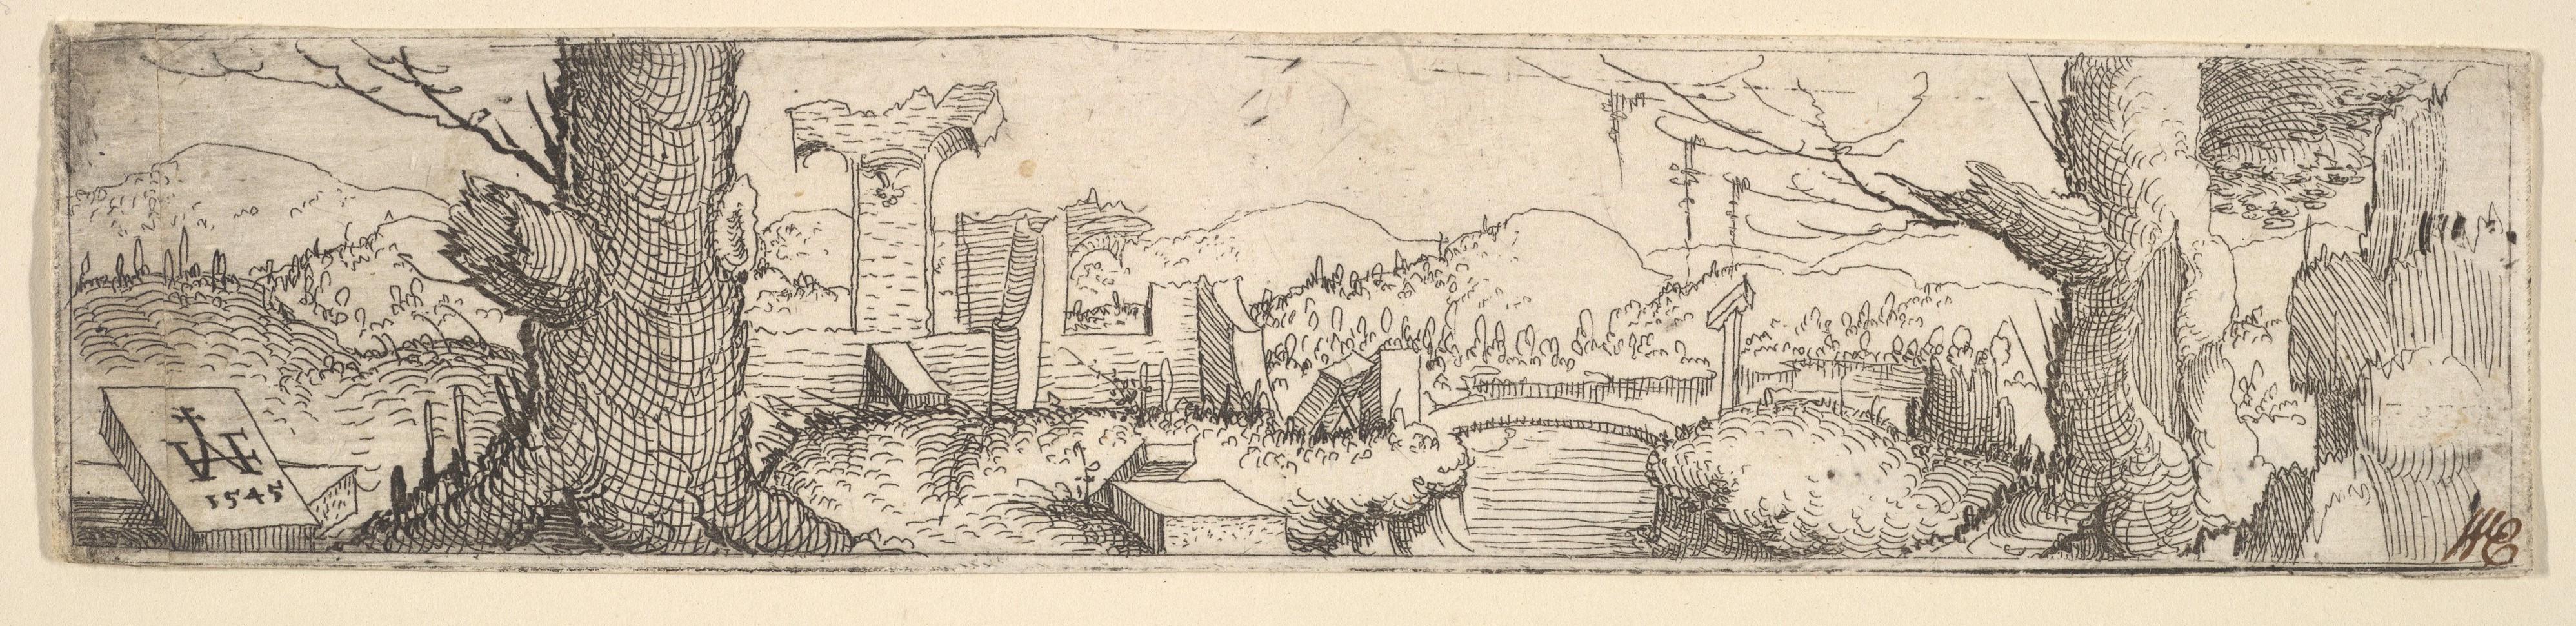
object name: print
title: Landscape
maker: augustin hirschvogel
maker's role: artist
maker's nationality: german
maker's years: 1503-1553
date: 1545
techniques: etching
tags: bridges,mountains,landscapes,trees